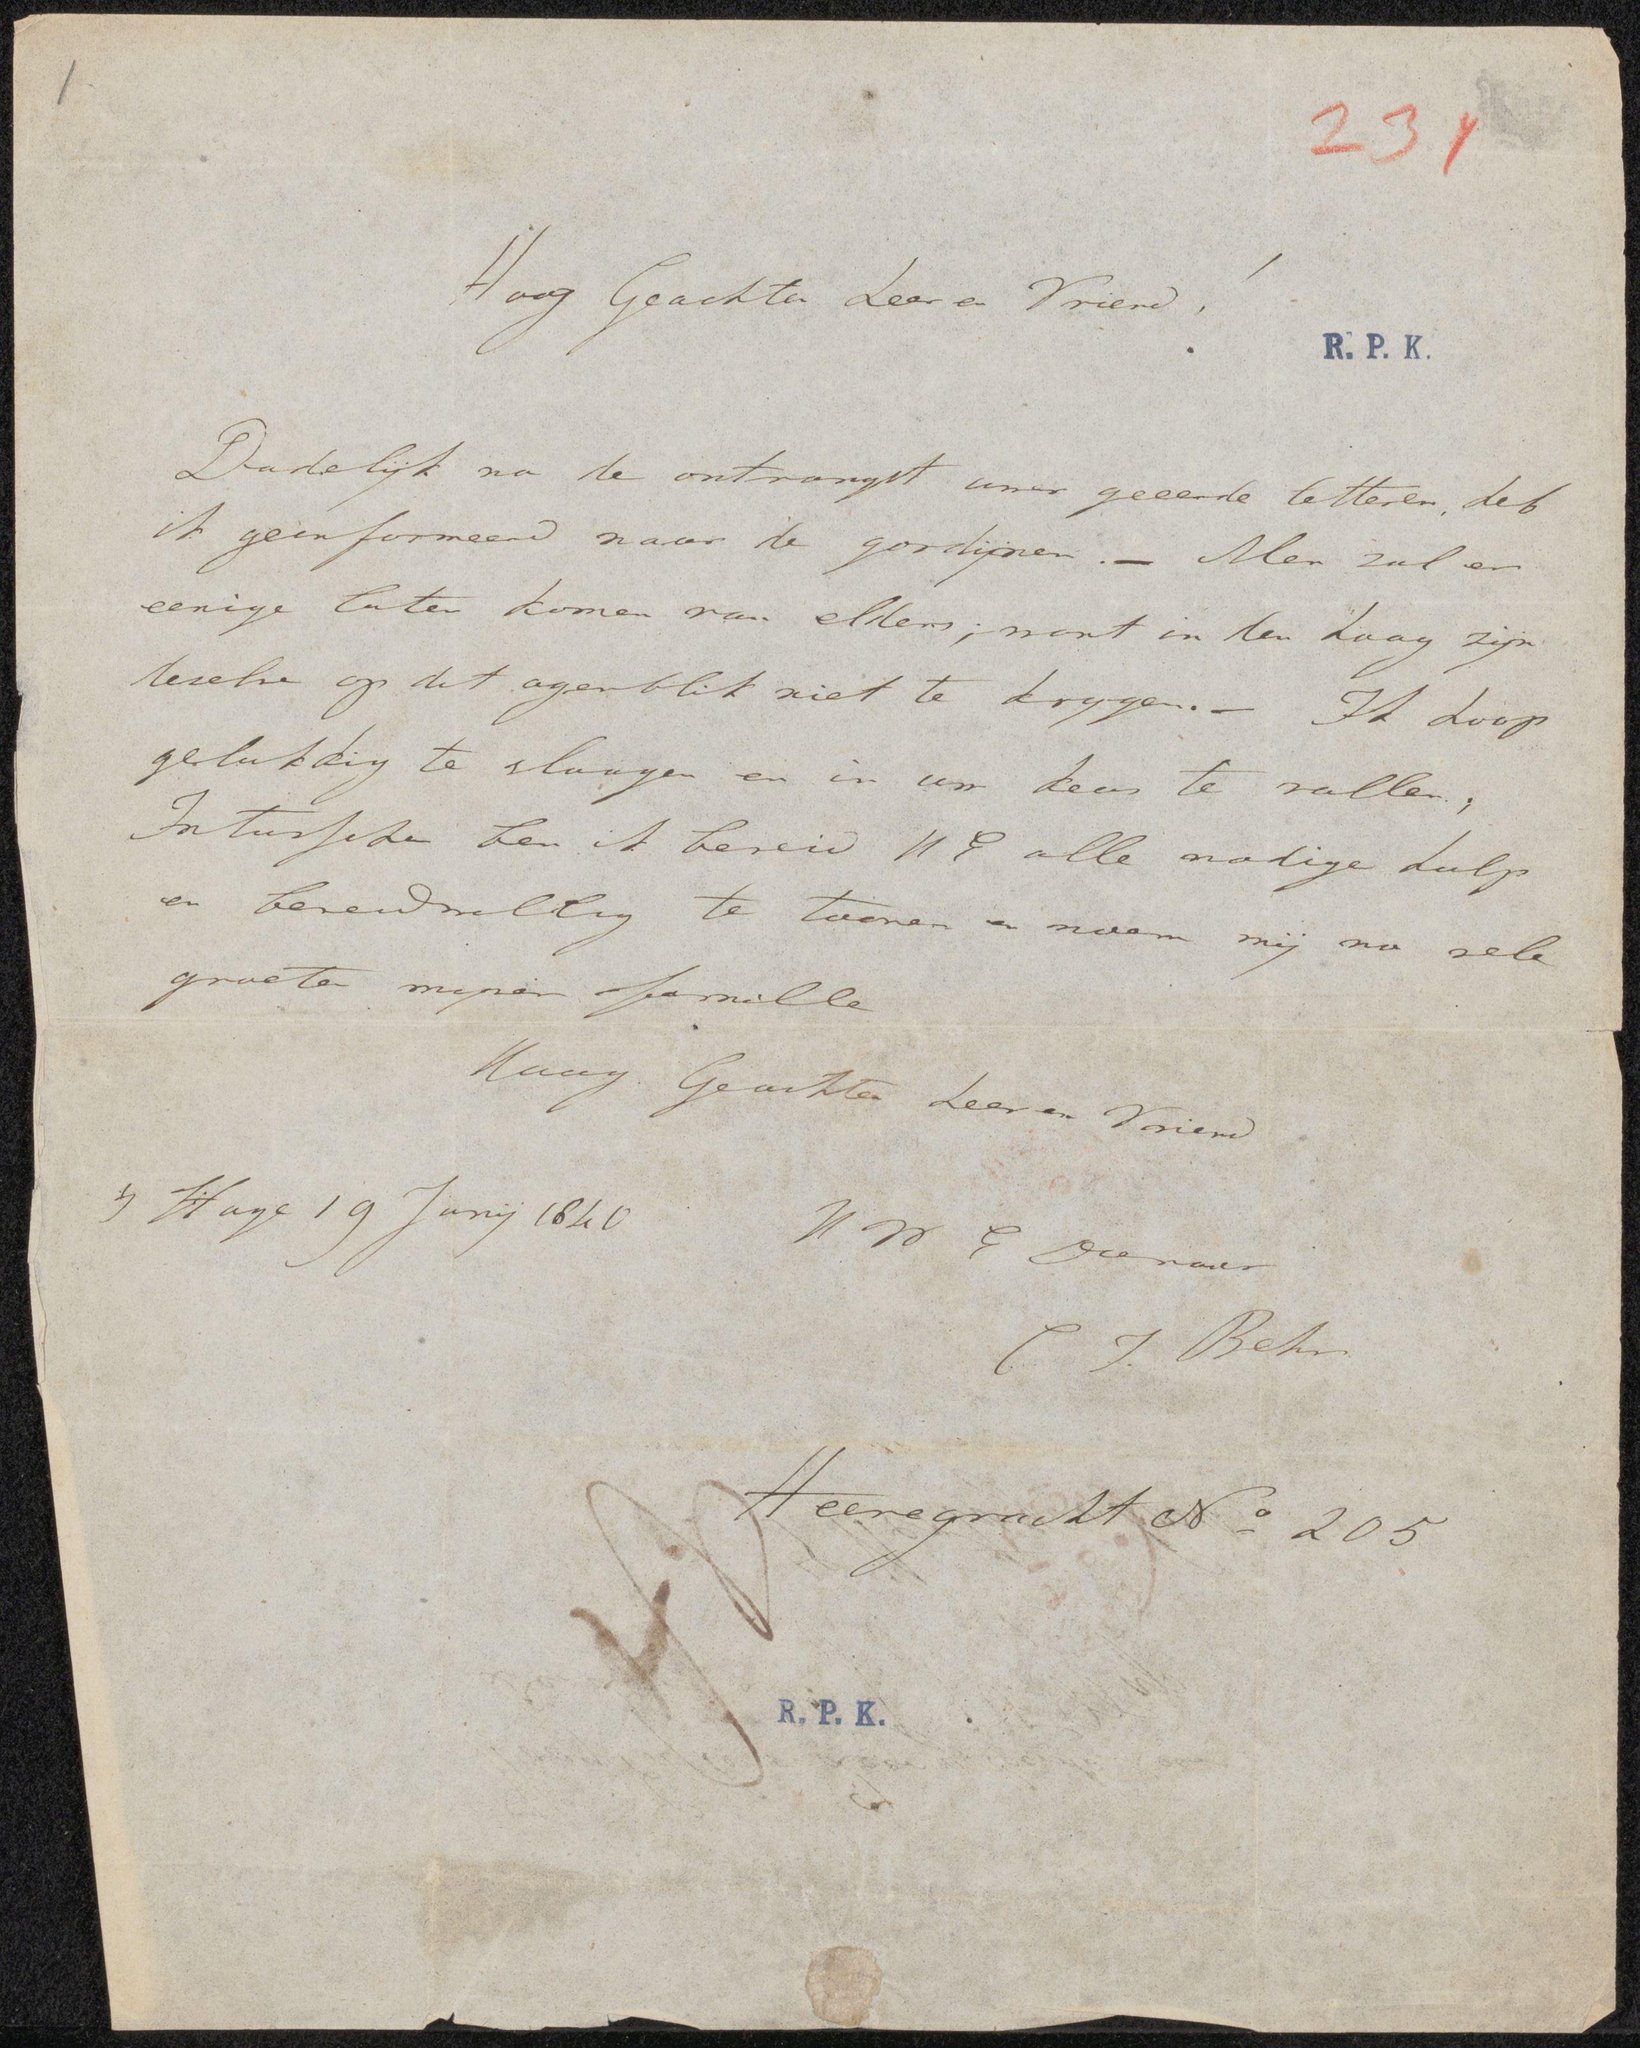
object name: letter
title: Brief aan Johannes Jacobus Franciscus Wap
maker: carel jacobus behr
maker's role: draughtsman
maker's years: 1812-1895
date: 1840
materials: ink, paper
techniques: pen, writing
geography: the hague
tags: johannes jacobus franciscus wap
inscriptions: collector's mark: ‘RPK’ Lugt 2233